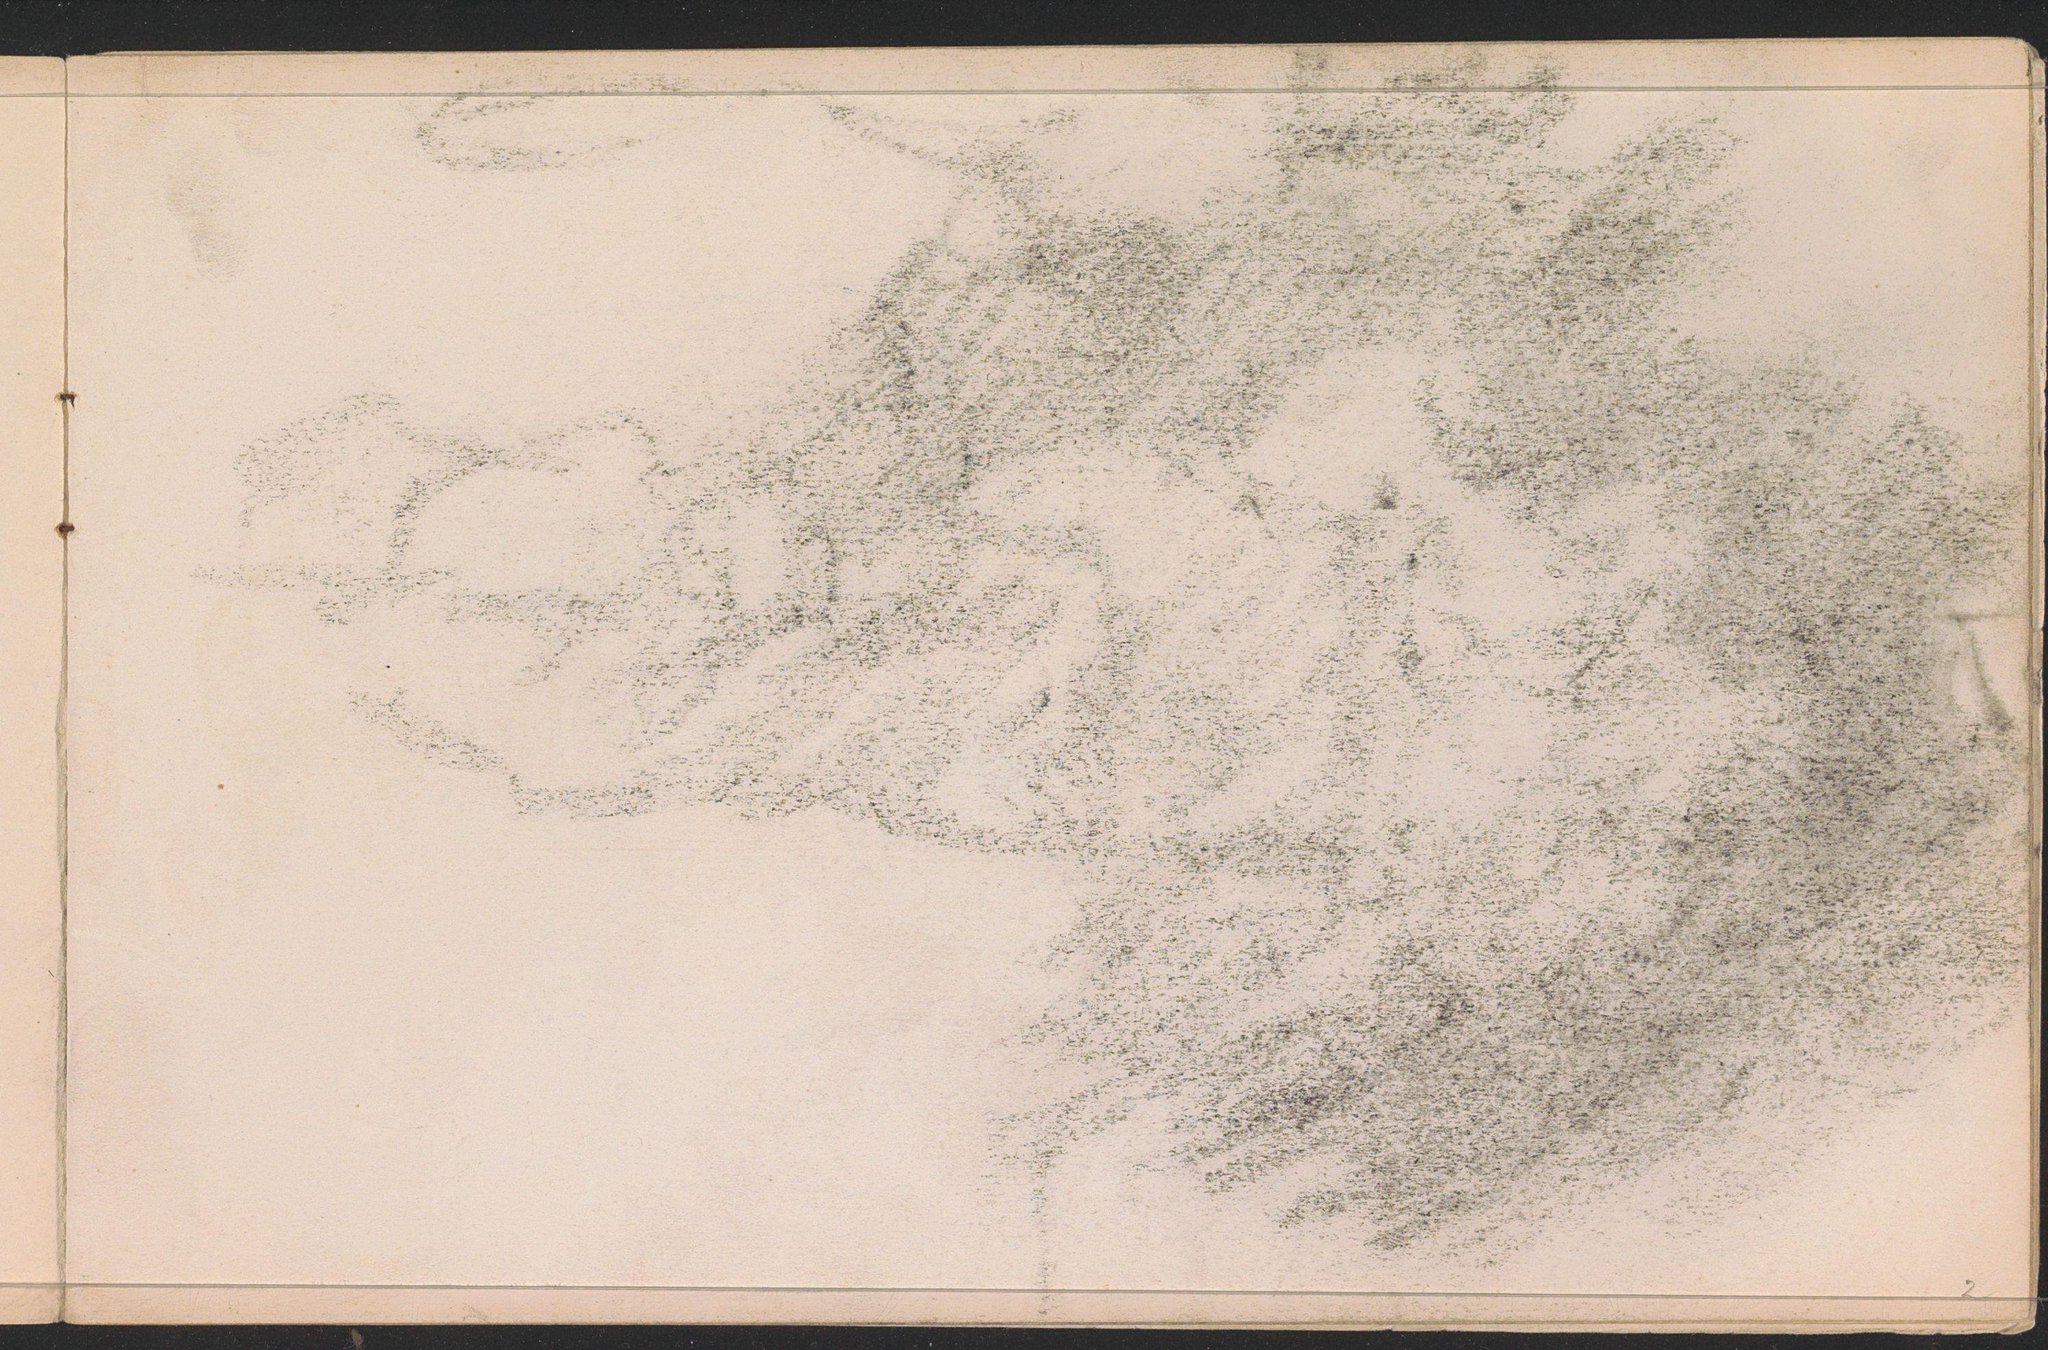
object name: sketchbook leaf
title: Abklatsch van een krijttekening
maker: isaac israels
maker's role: draughtsman, painter, print maker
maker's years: 1865-1934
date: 1875-1934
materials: paper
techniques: printmaking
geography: paris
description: De originele tekening is niet meer in het schetsboek aanwezig. Blad 2 recto uit schetsboek LI met 11 bladen.